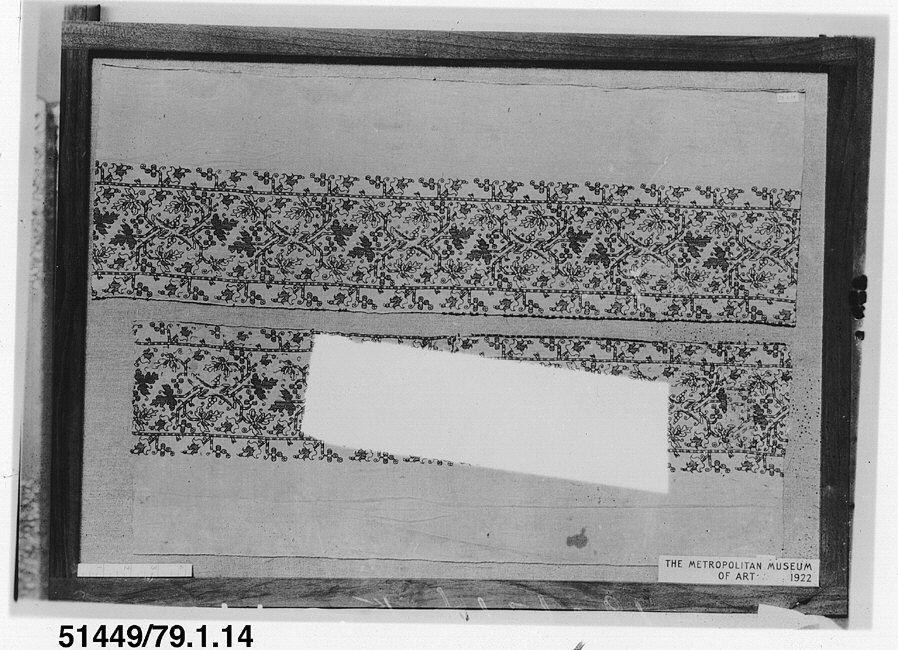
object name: border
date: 1501-1600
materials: linen, silk